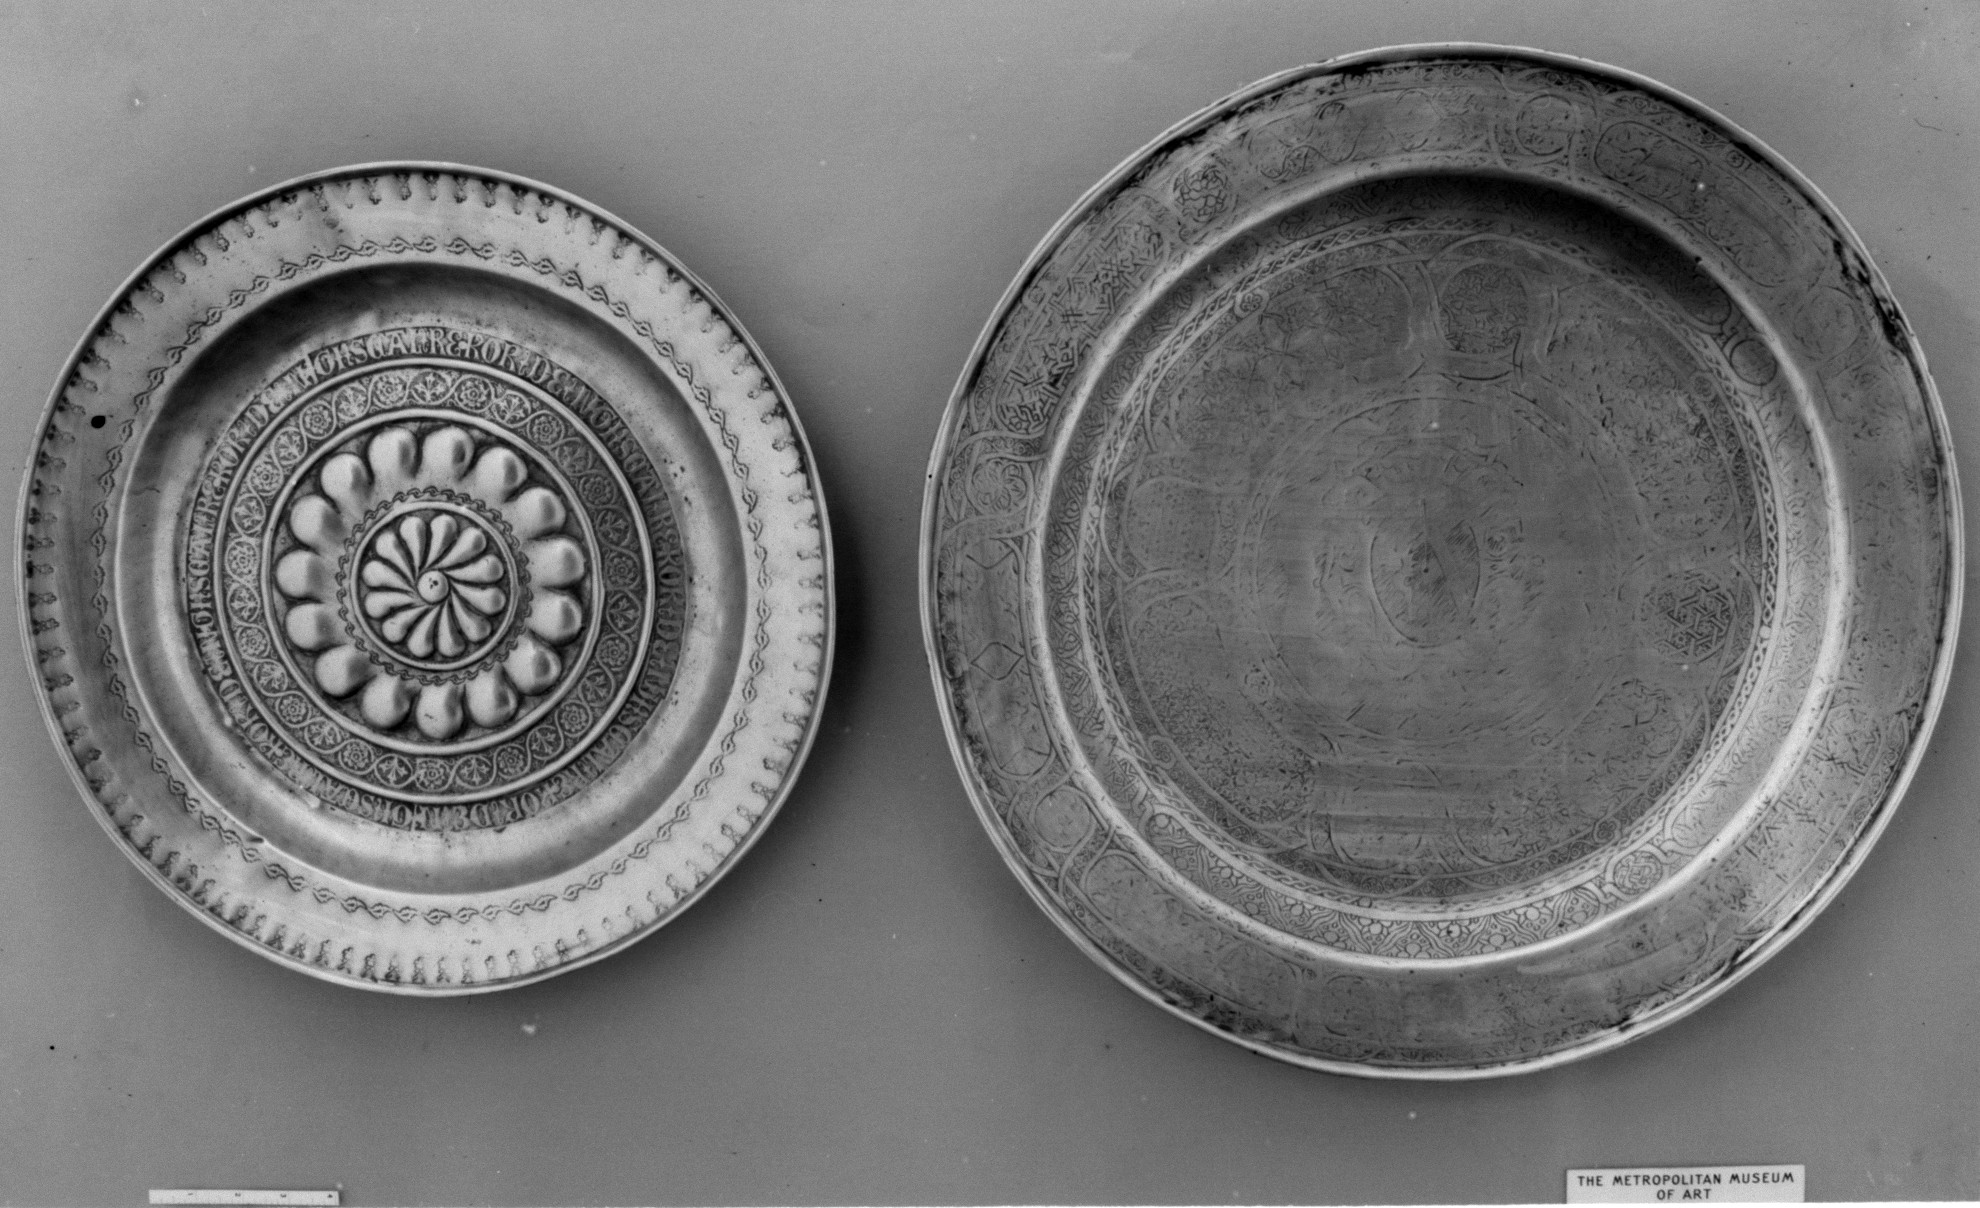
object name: plate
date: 1501-1600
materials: brass